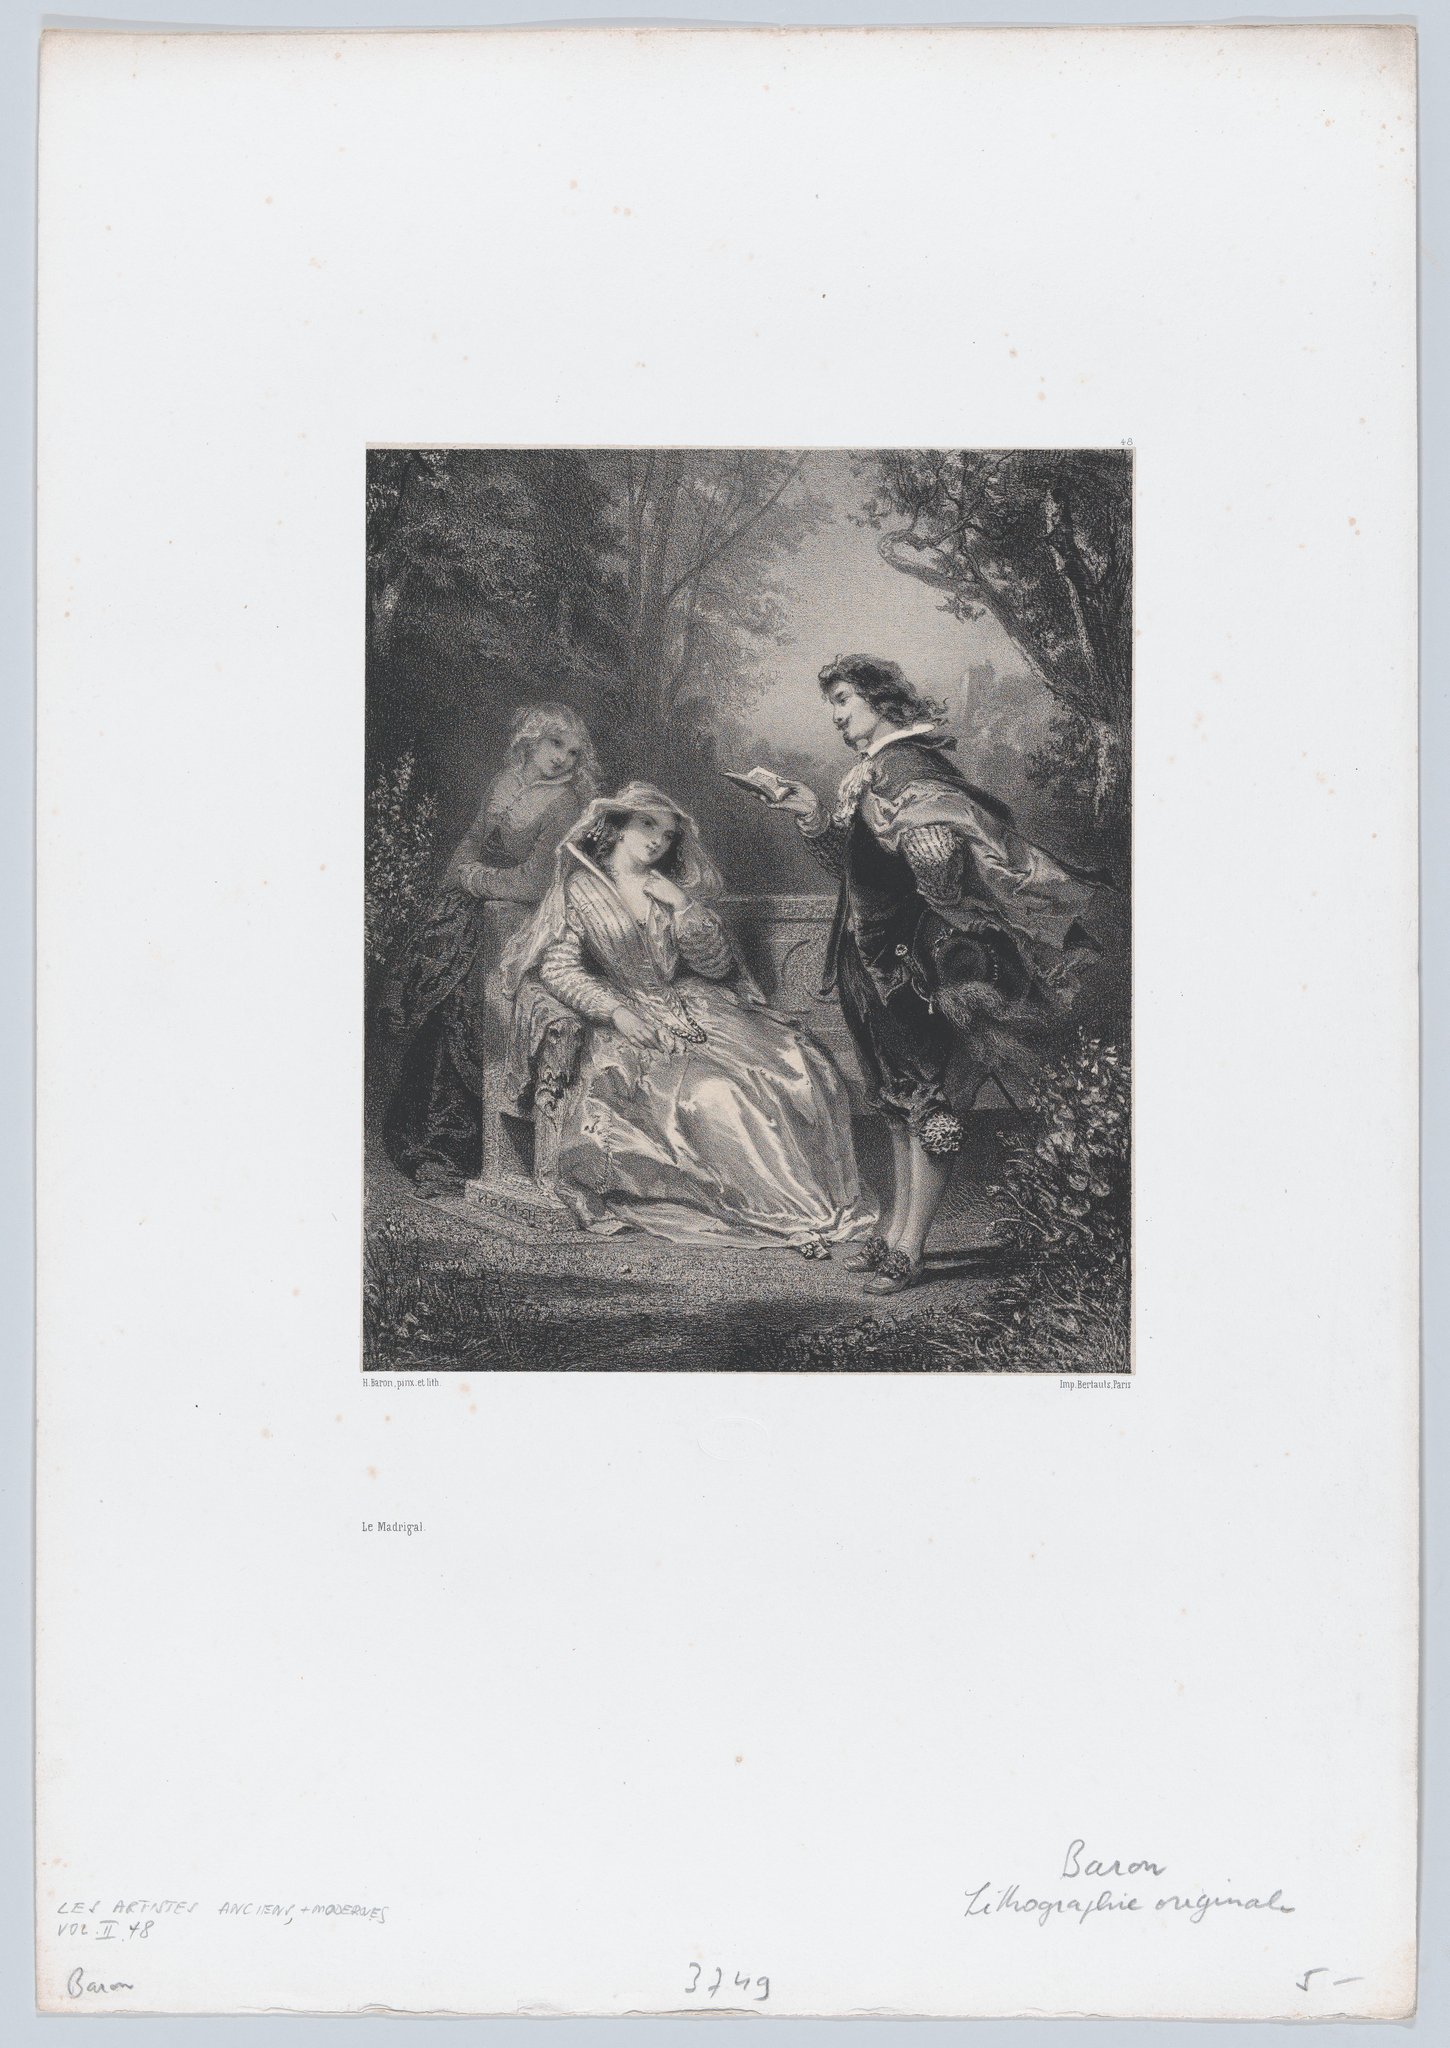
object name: print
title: The Madrigal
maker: henri-charles-antoine baron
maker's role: artist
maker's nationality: french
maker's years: 1816-1885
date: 1850-1855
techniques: lithograph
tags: men,women,trees